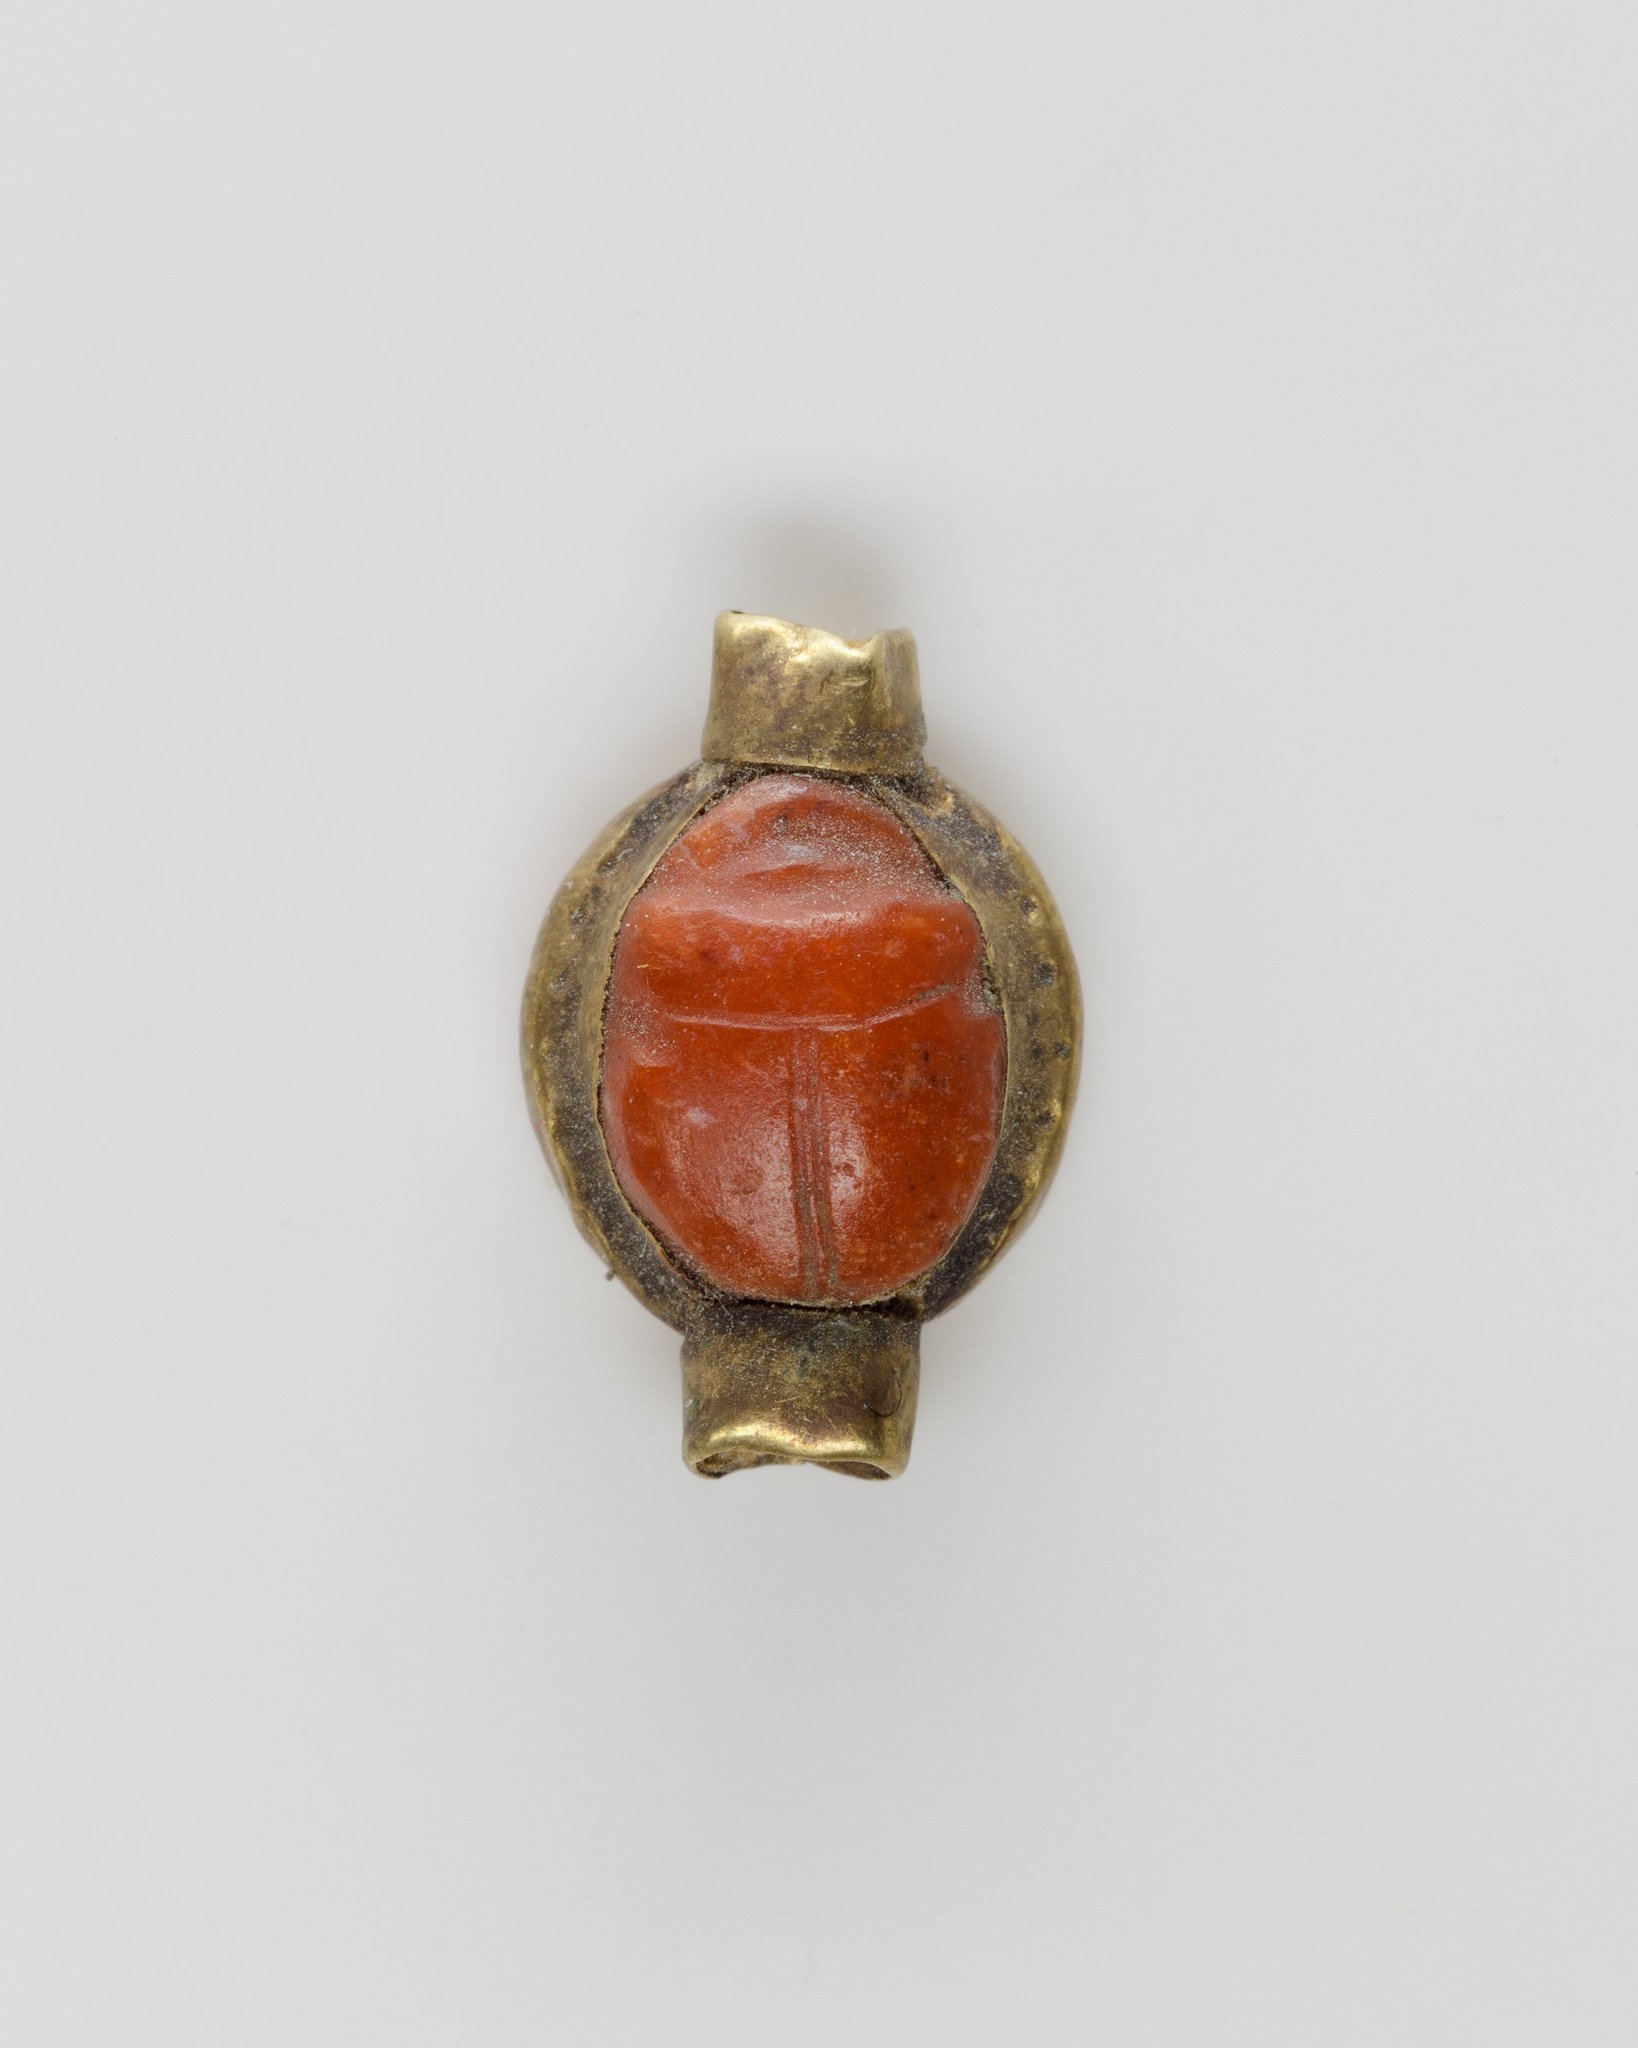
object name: scarab, amenhotep, ring, swivel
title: Scarab set in a ring bezel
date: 1479-1458 BCE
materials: gemstone, gold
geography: egypt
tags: scarabs